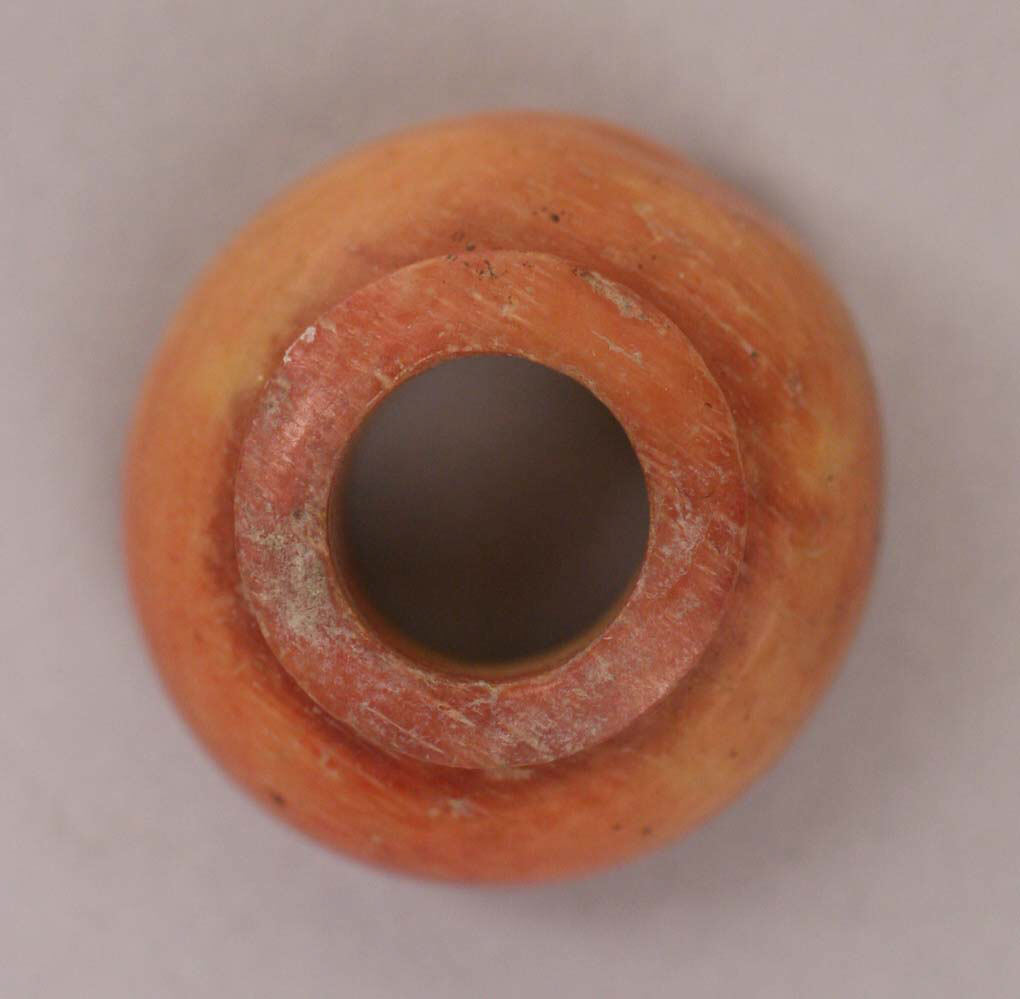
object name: button or bead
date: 801-1000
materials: bone, paint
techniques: incising, inlay, tinting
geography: iran